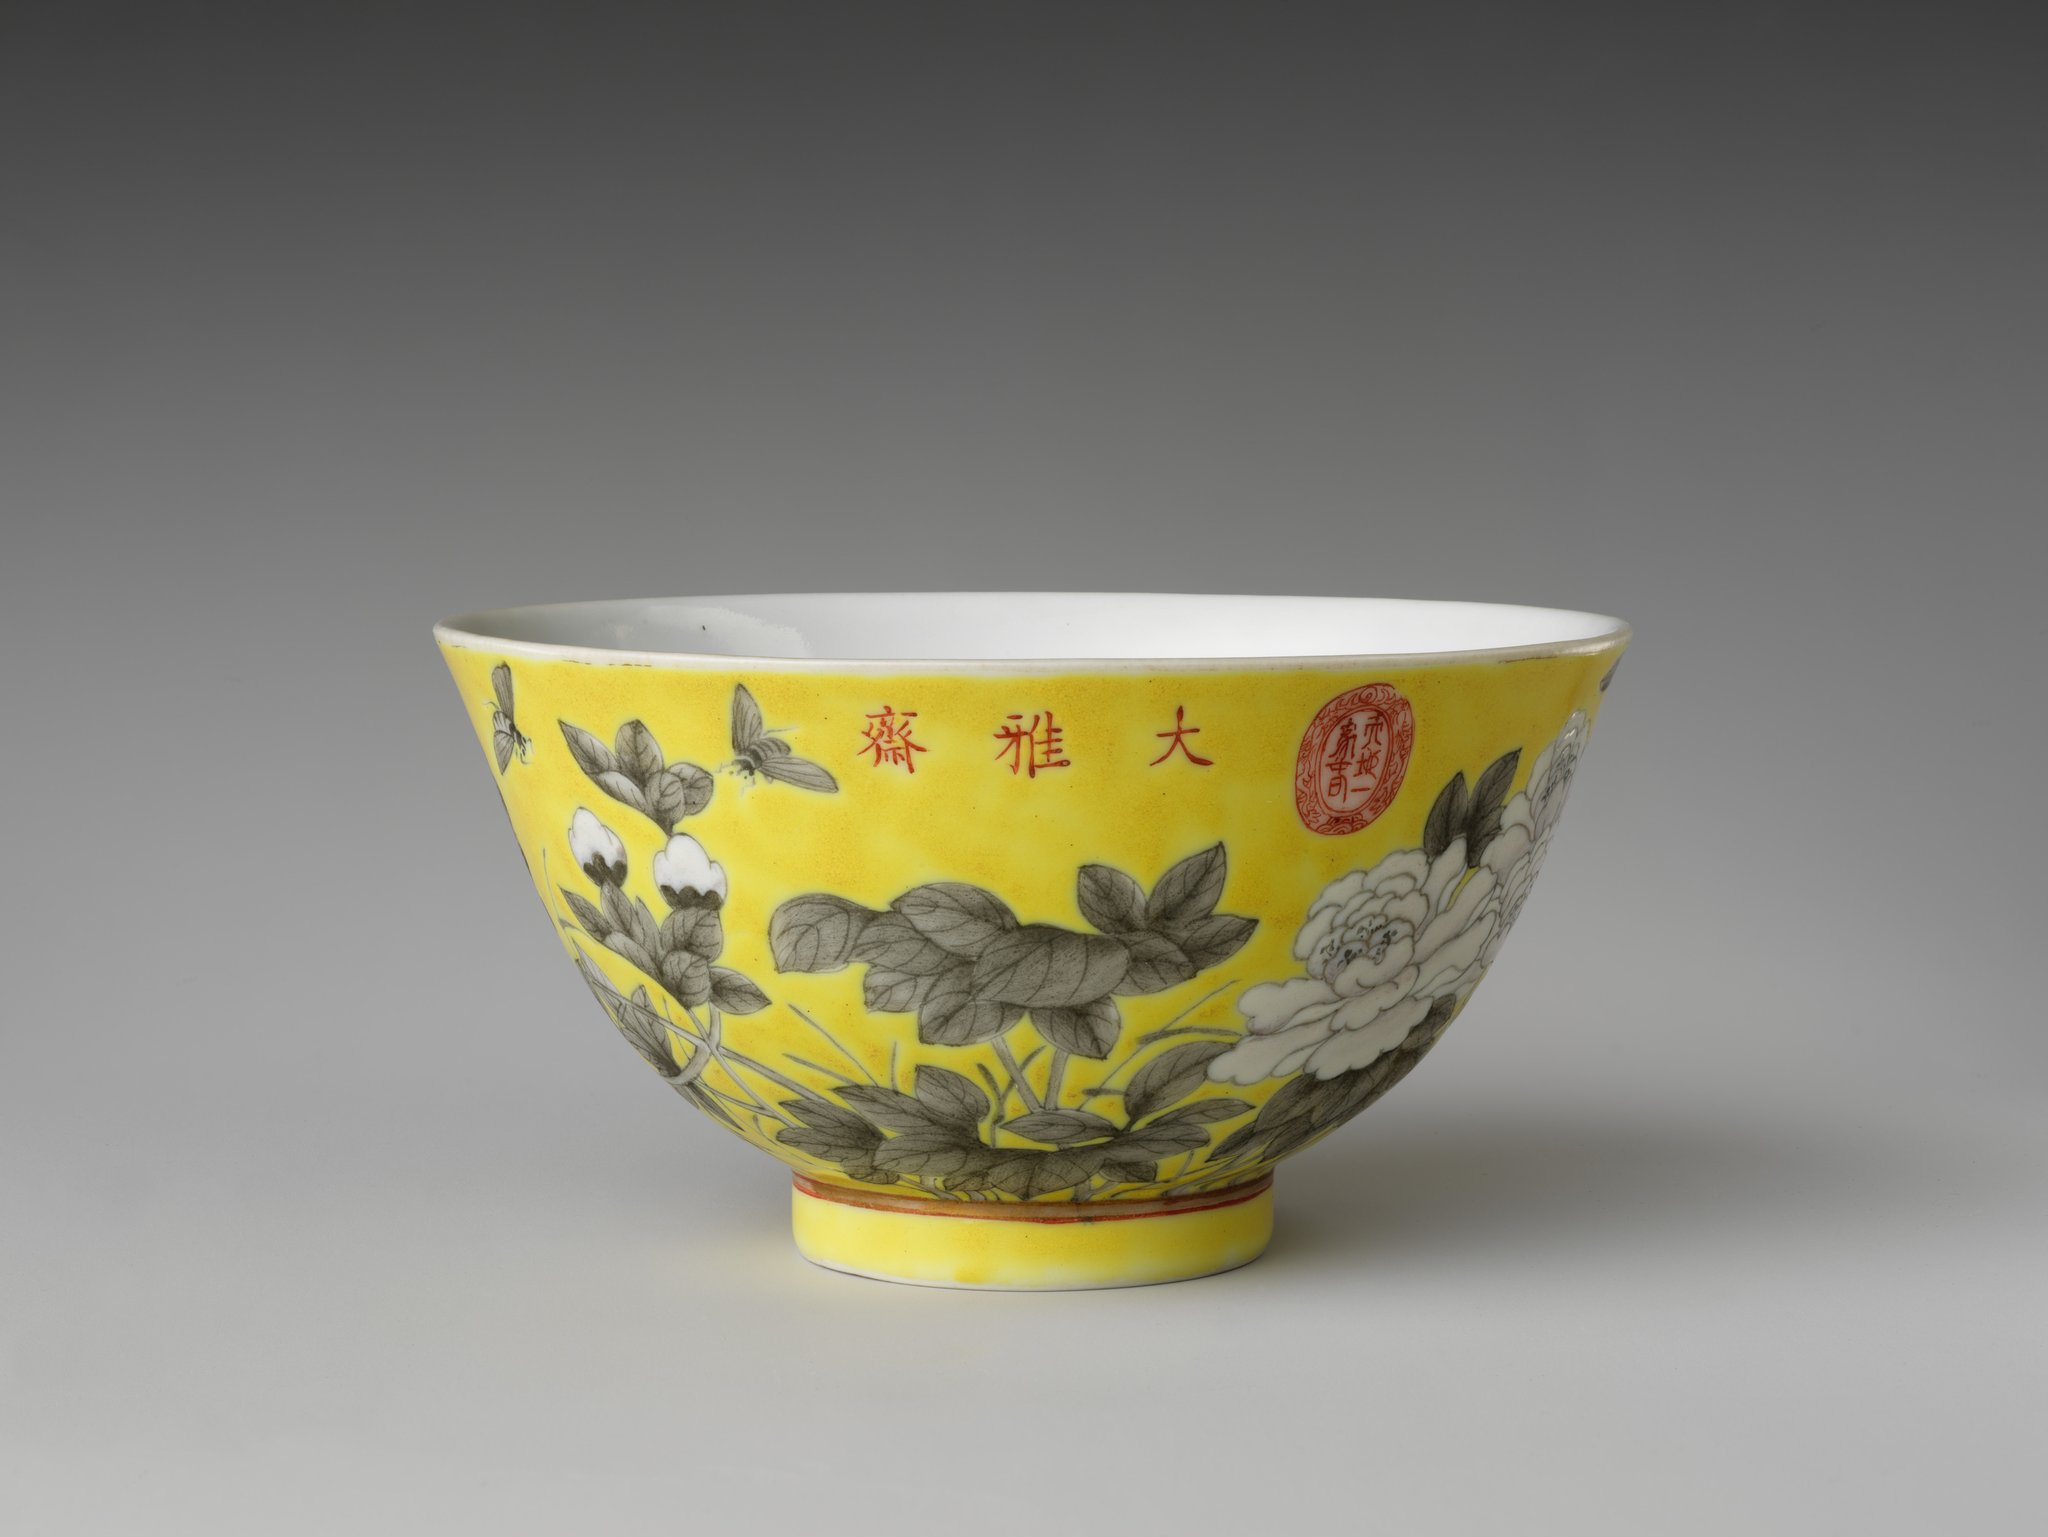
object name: bowl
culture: chinese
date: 1875-1908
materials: enamel, gilt, porcelain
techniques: overglaze, painting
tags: insects,flowers